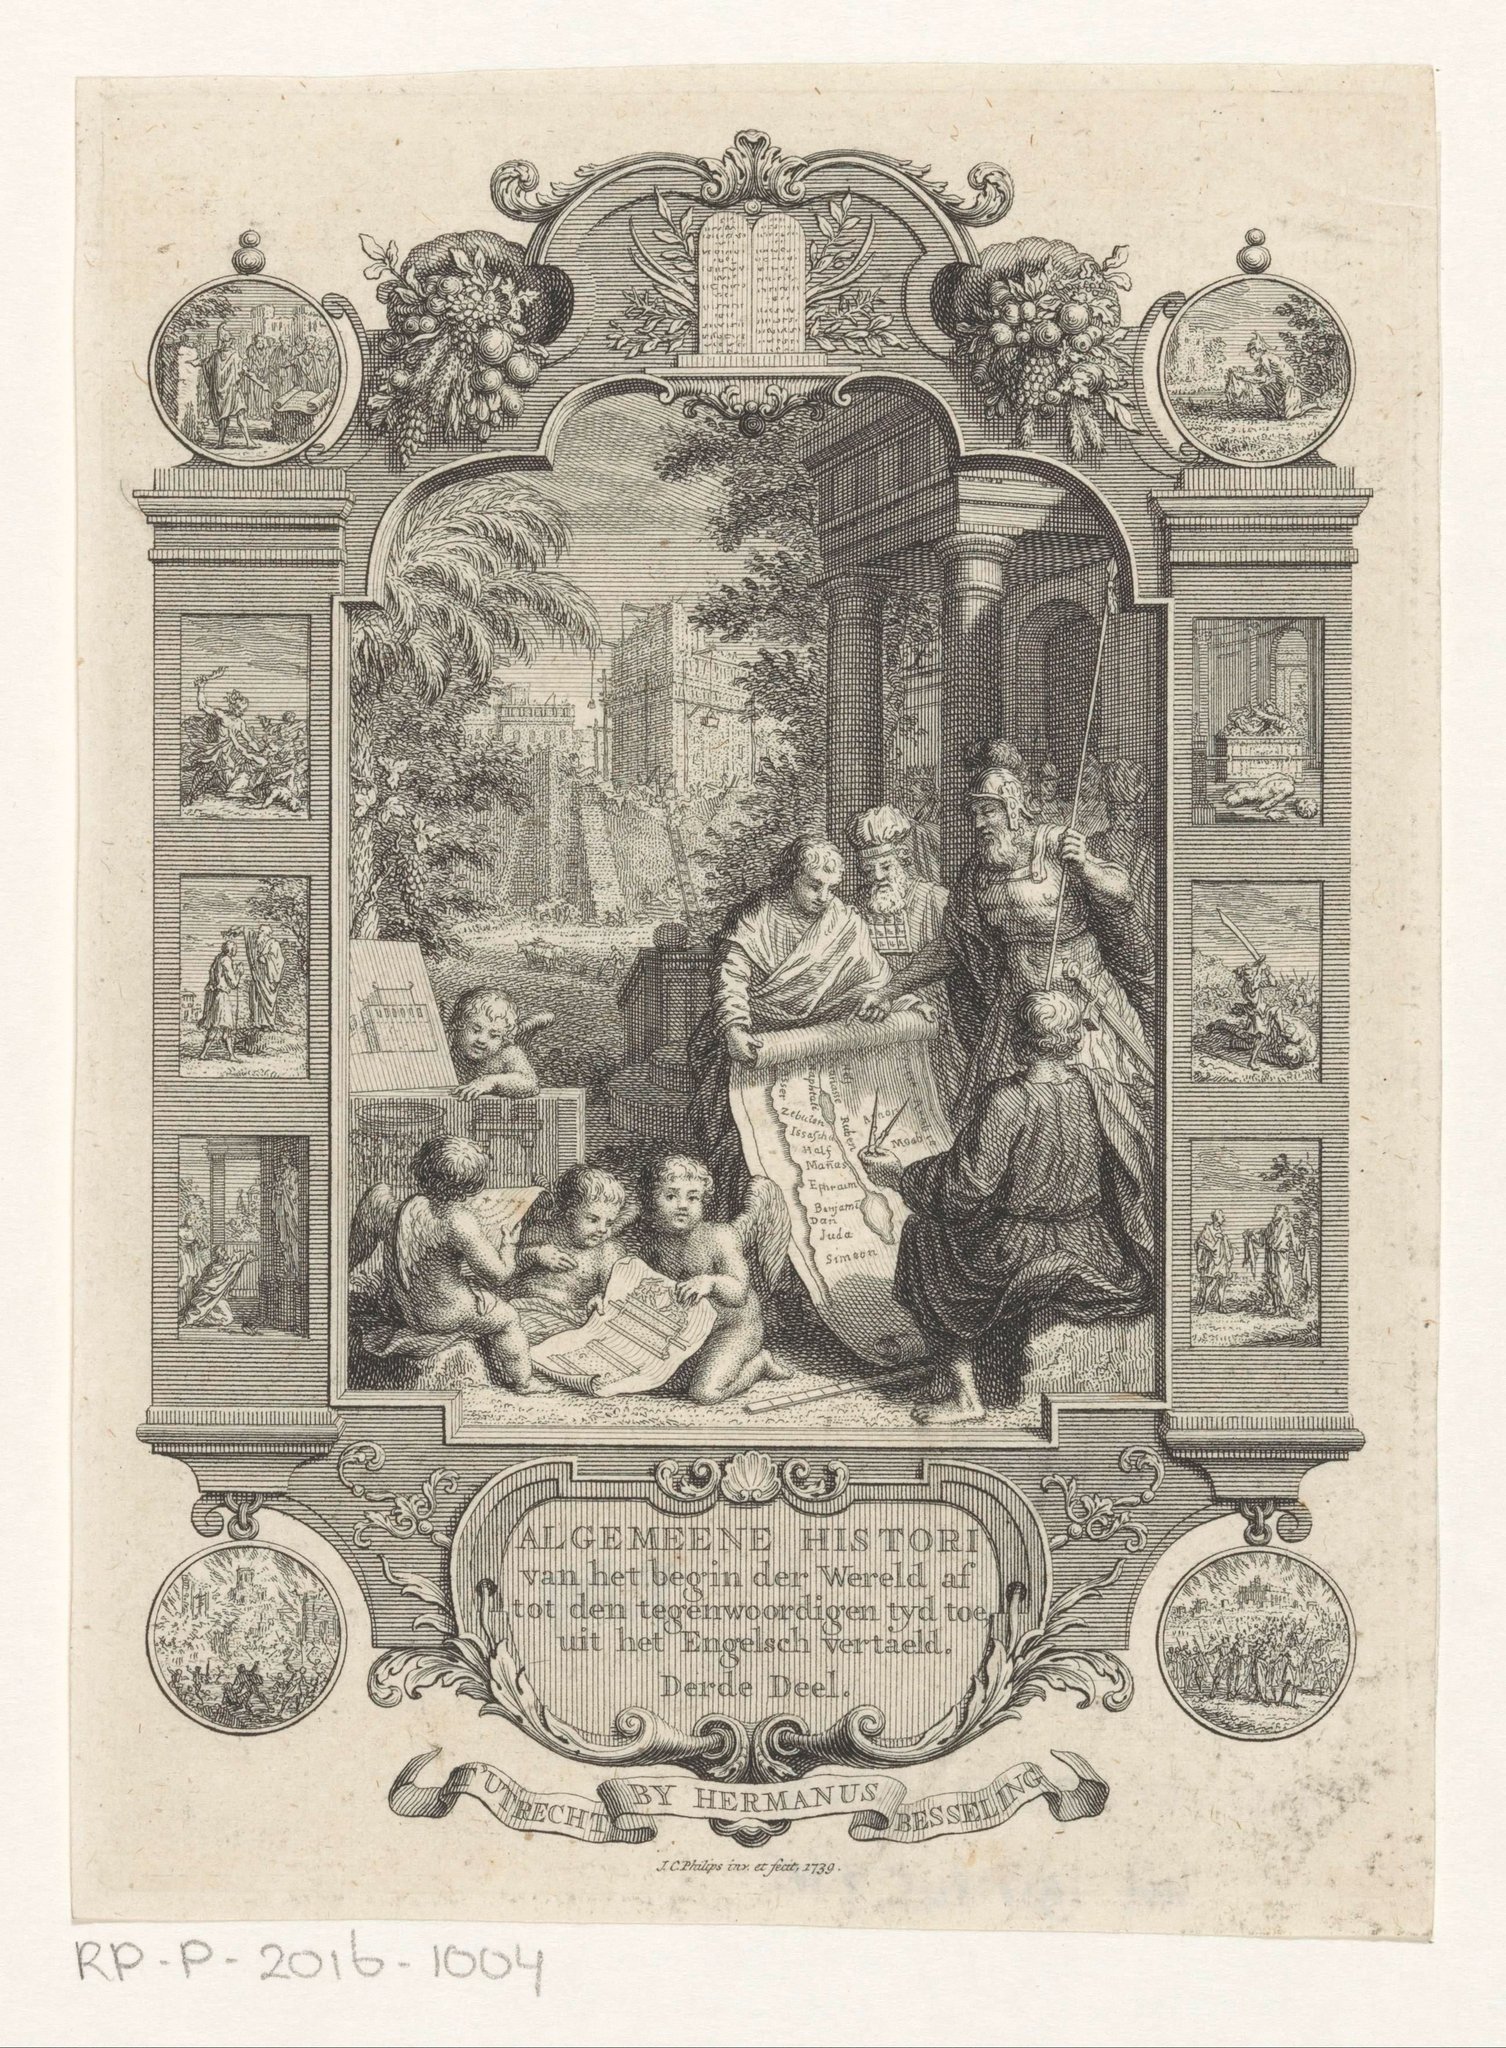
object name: print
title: Titelpagina voor: Kornelis Westerbaen, Algemeene histori, 1738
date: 1738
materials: paper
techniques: engraving, etching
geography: utrecht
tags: the twelve patriarchs together, i.e. the twelve (grand)sons of jacob, eponymous ancestors of the twelve tribes of israel, the division of canaan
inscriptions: collector's mark: Lugt 2228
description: Jozua en de priester Eleazar staan bij een kaart van Kanaän waarbij ook twee jongemannen staan. Zij verdelen het gebied onder de twaalf stammen van Israël (voortgekomen uit de zonen van aartsvader Jakob). Achter hen staat een koning onder een portico. Links zitten putti met tekeningen van onder andere een altaar en een zevenarmige kandelaar. In de achtergrond worden gebouwen opgetrokken. In de omlijsting van de cartouche Bijbelse scènes.